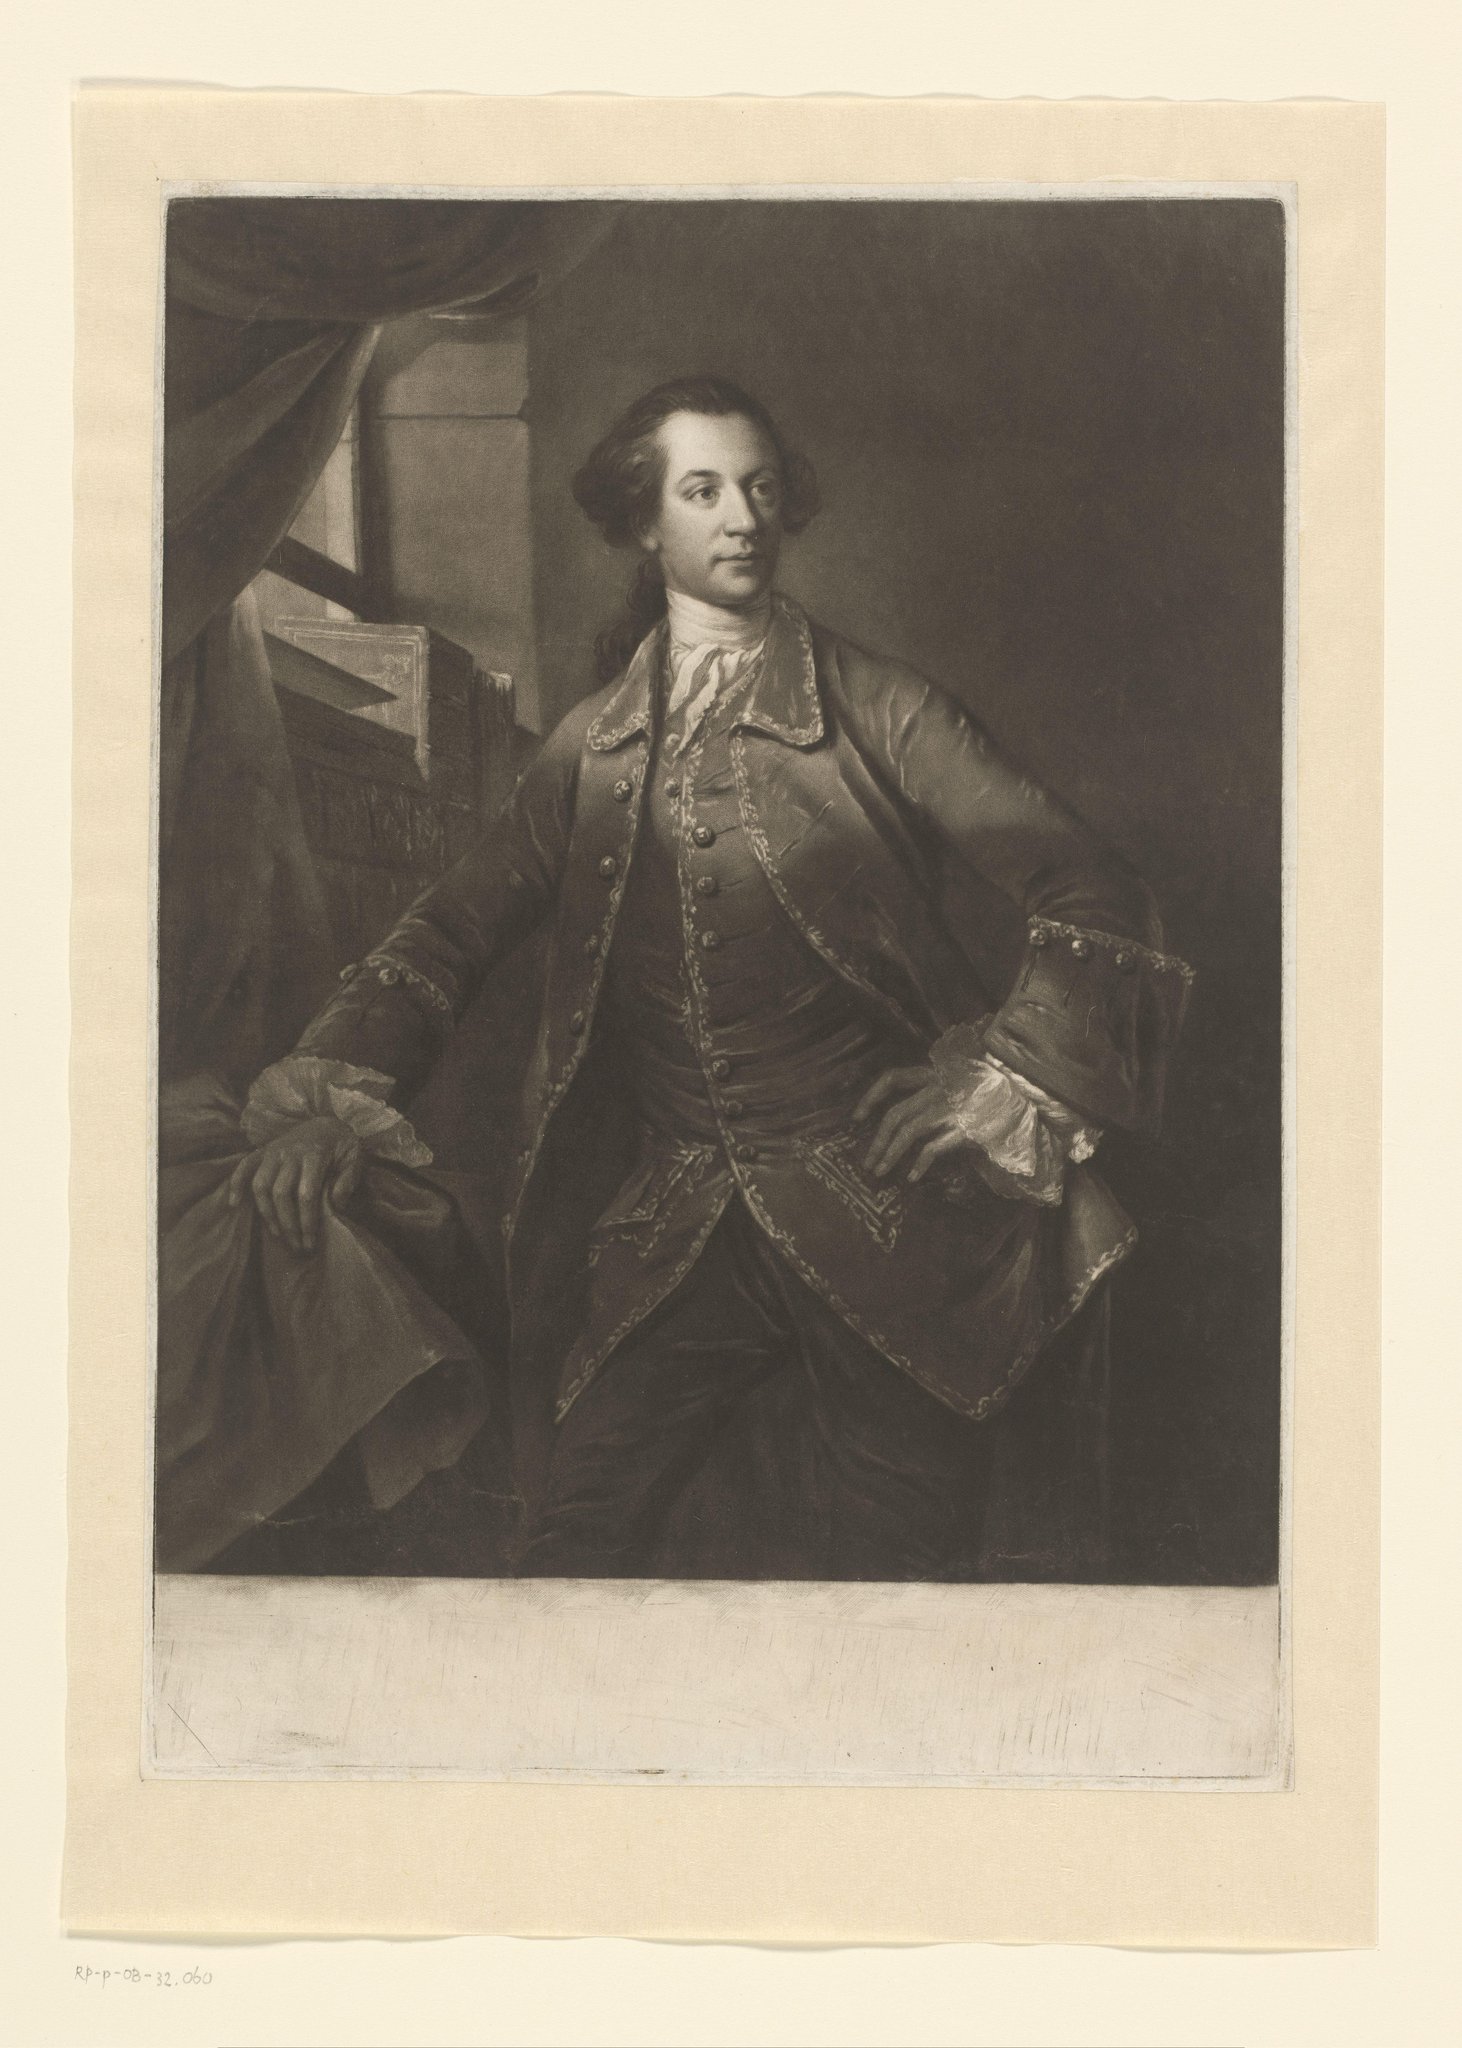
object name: print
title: Portret van Charles Watson-Wentworth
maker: richard houston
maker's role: print maker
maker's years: 1721-1775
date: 1731-1775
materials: paper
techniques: mezzotint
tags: politician, charles watson-wentworth (2e markies van rockingham), historical persons, politician, e.g. party leader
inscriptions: collector's mark: Lugt 240